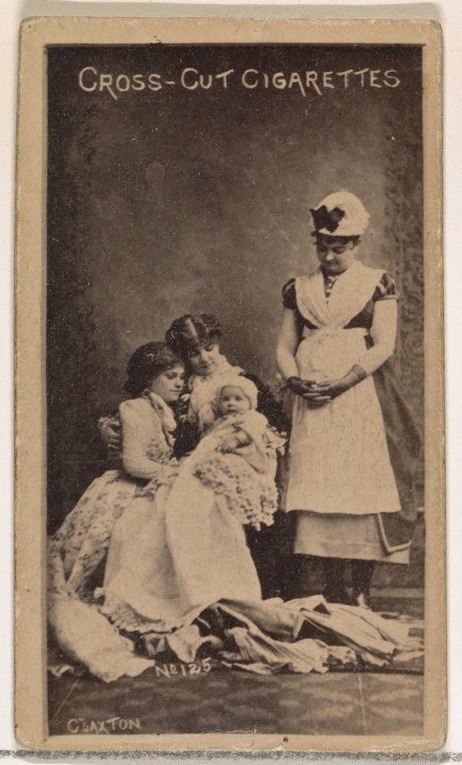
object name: print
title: Card Number 125, Claxton, from the Actors and Actresses series (N145-1) issued by Duke Sons & Co. to promote Cross Cut Cigarettes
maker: w. duke, sons & co.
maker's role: publisher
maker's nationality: american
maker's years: 1870-1920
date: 1880-1889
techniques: albumen silver print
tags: infants,women,actresses